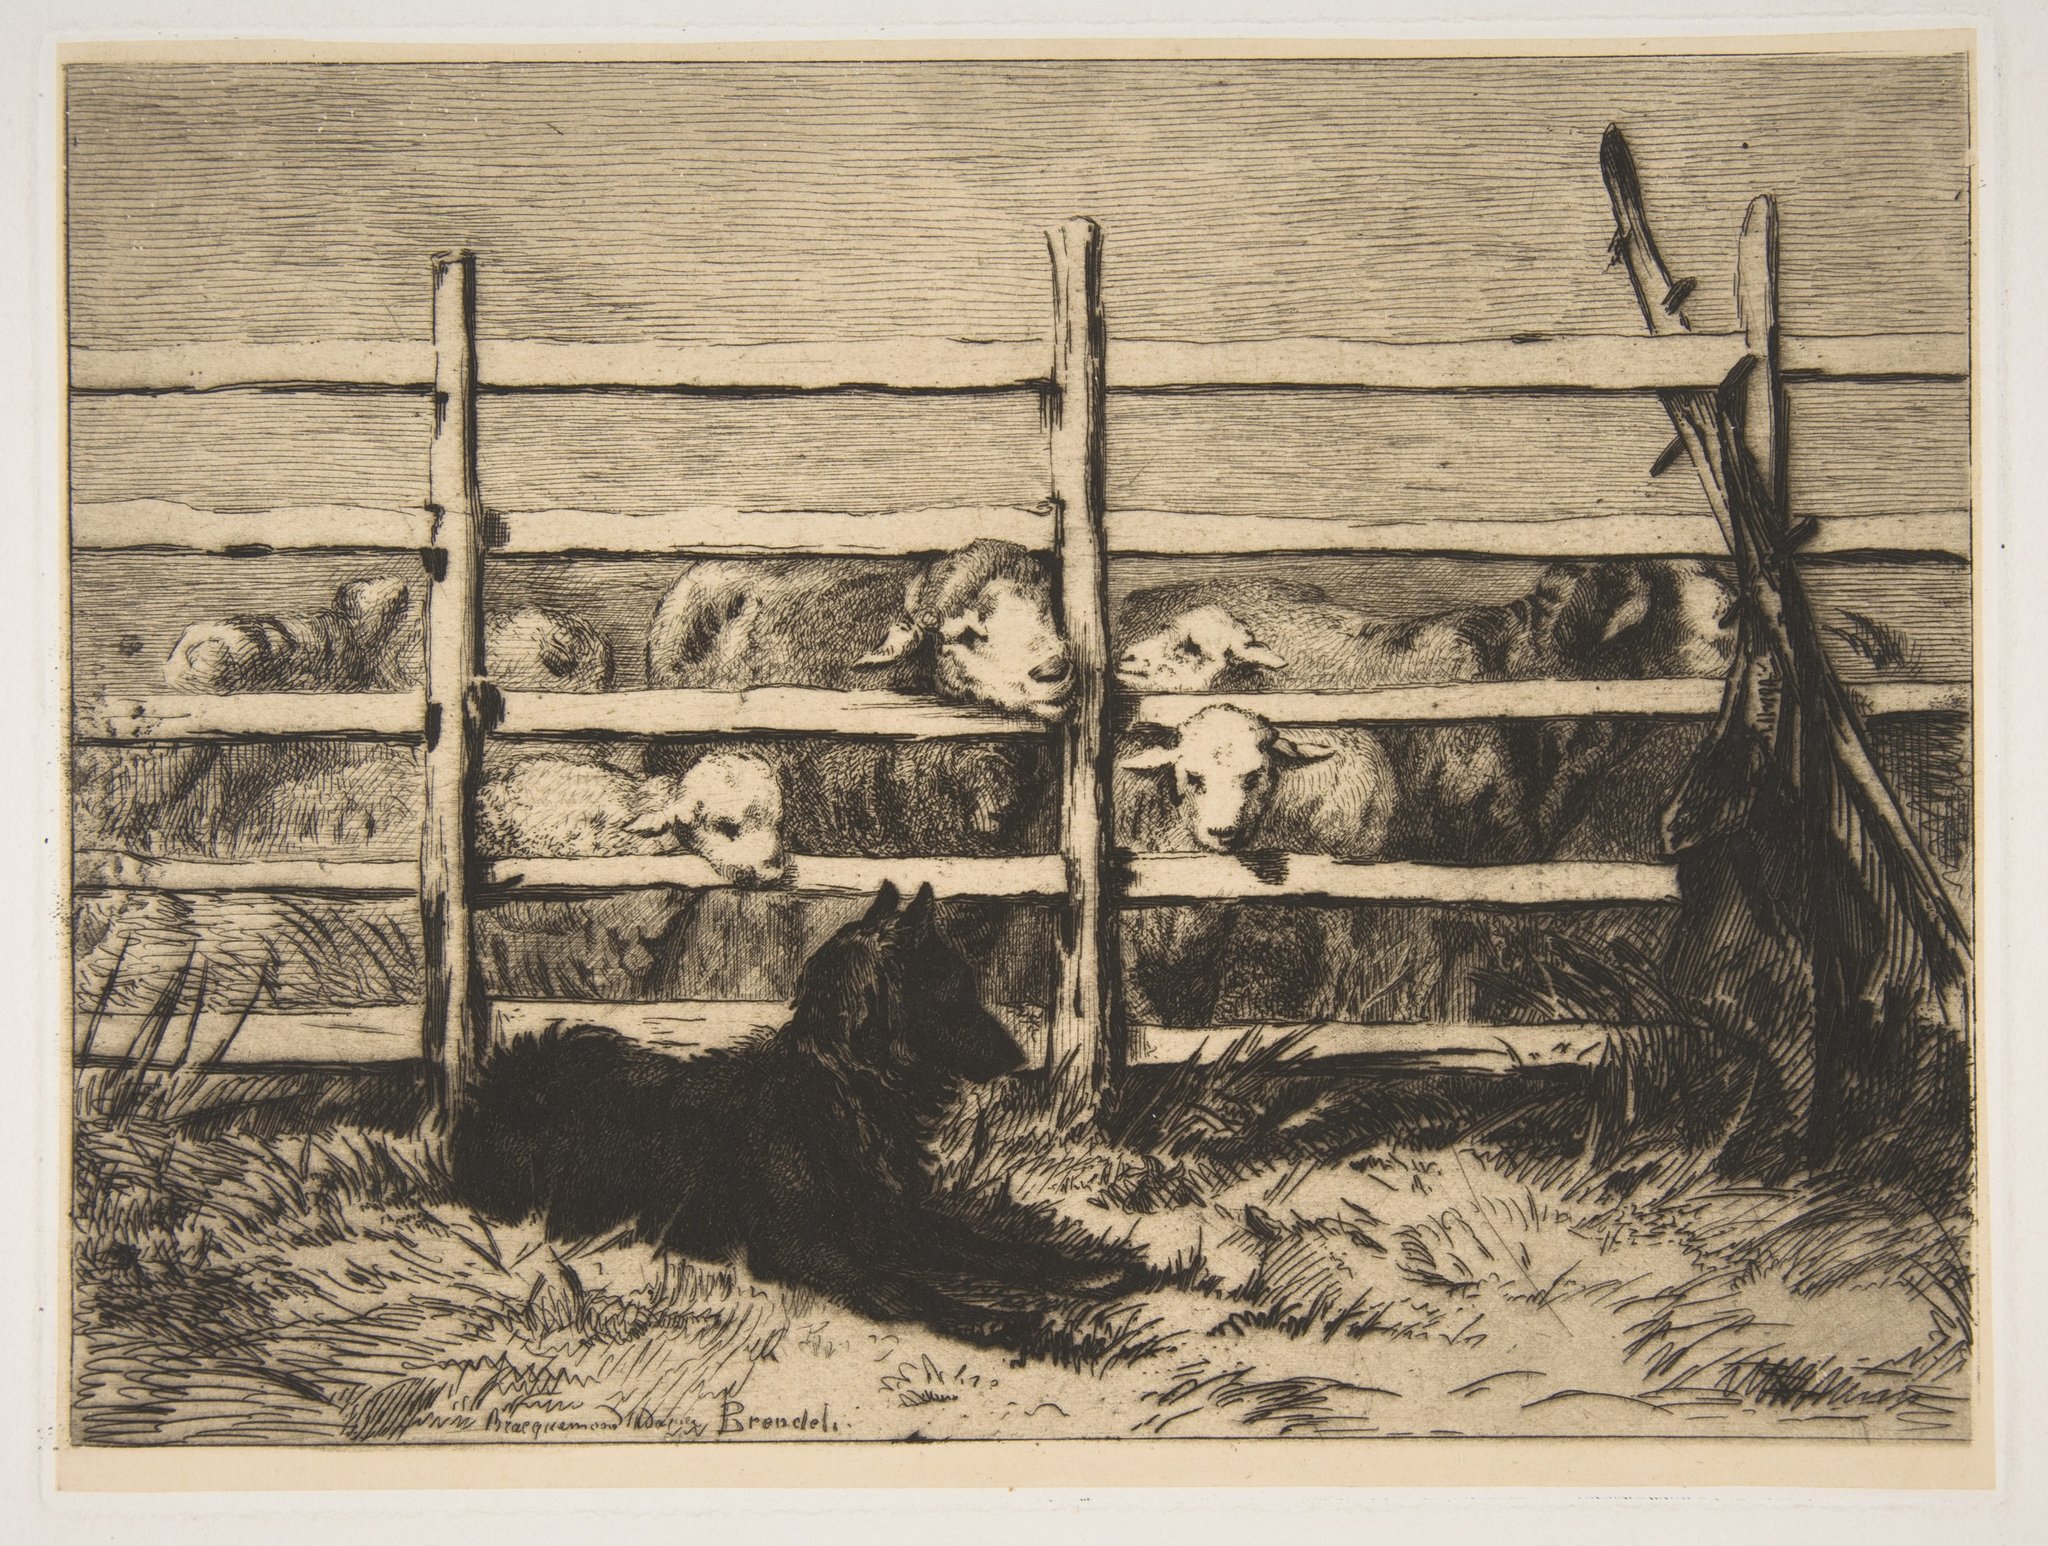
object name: print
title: Moutons Parqués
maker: félix bracquemond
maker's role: artist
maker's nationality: french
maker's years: 1833-1914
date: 1856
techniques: etching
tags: dogs,sheep